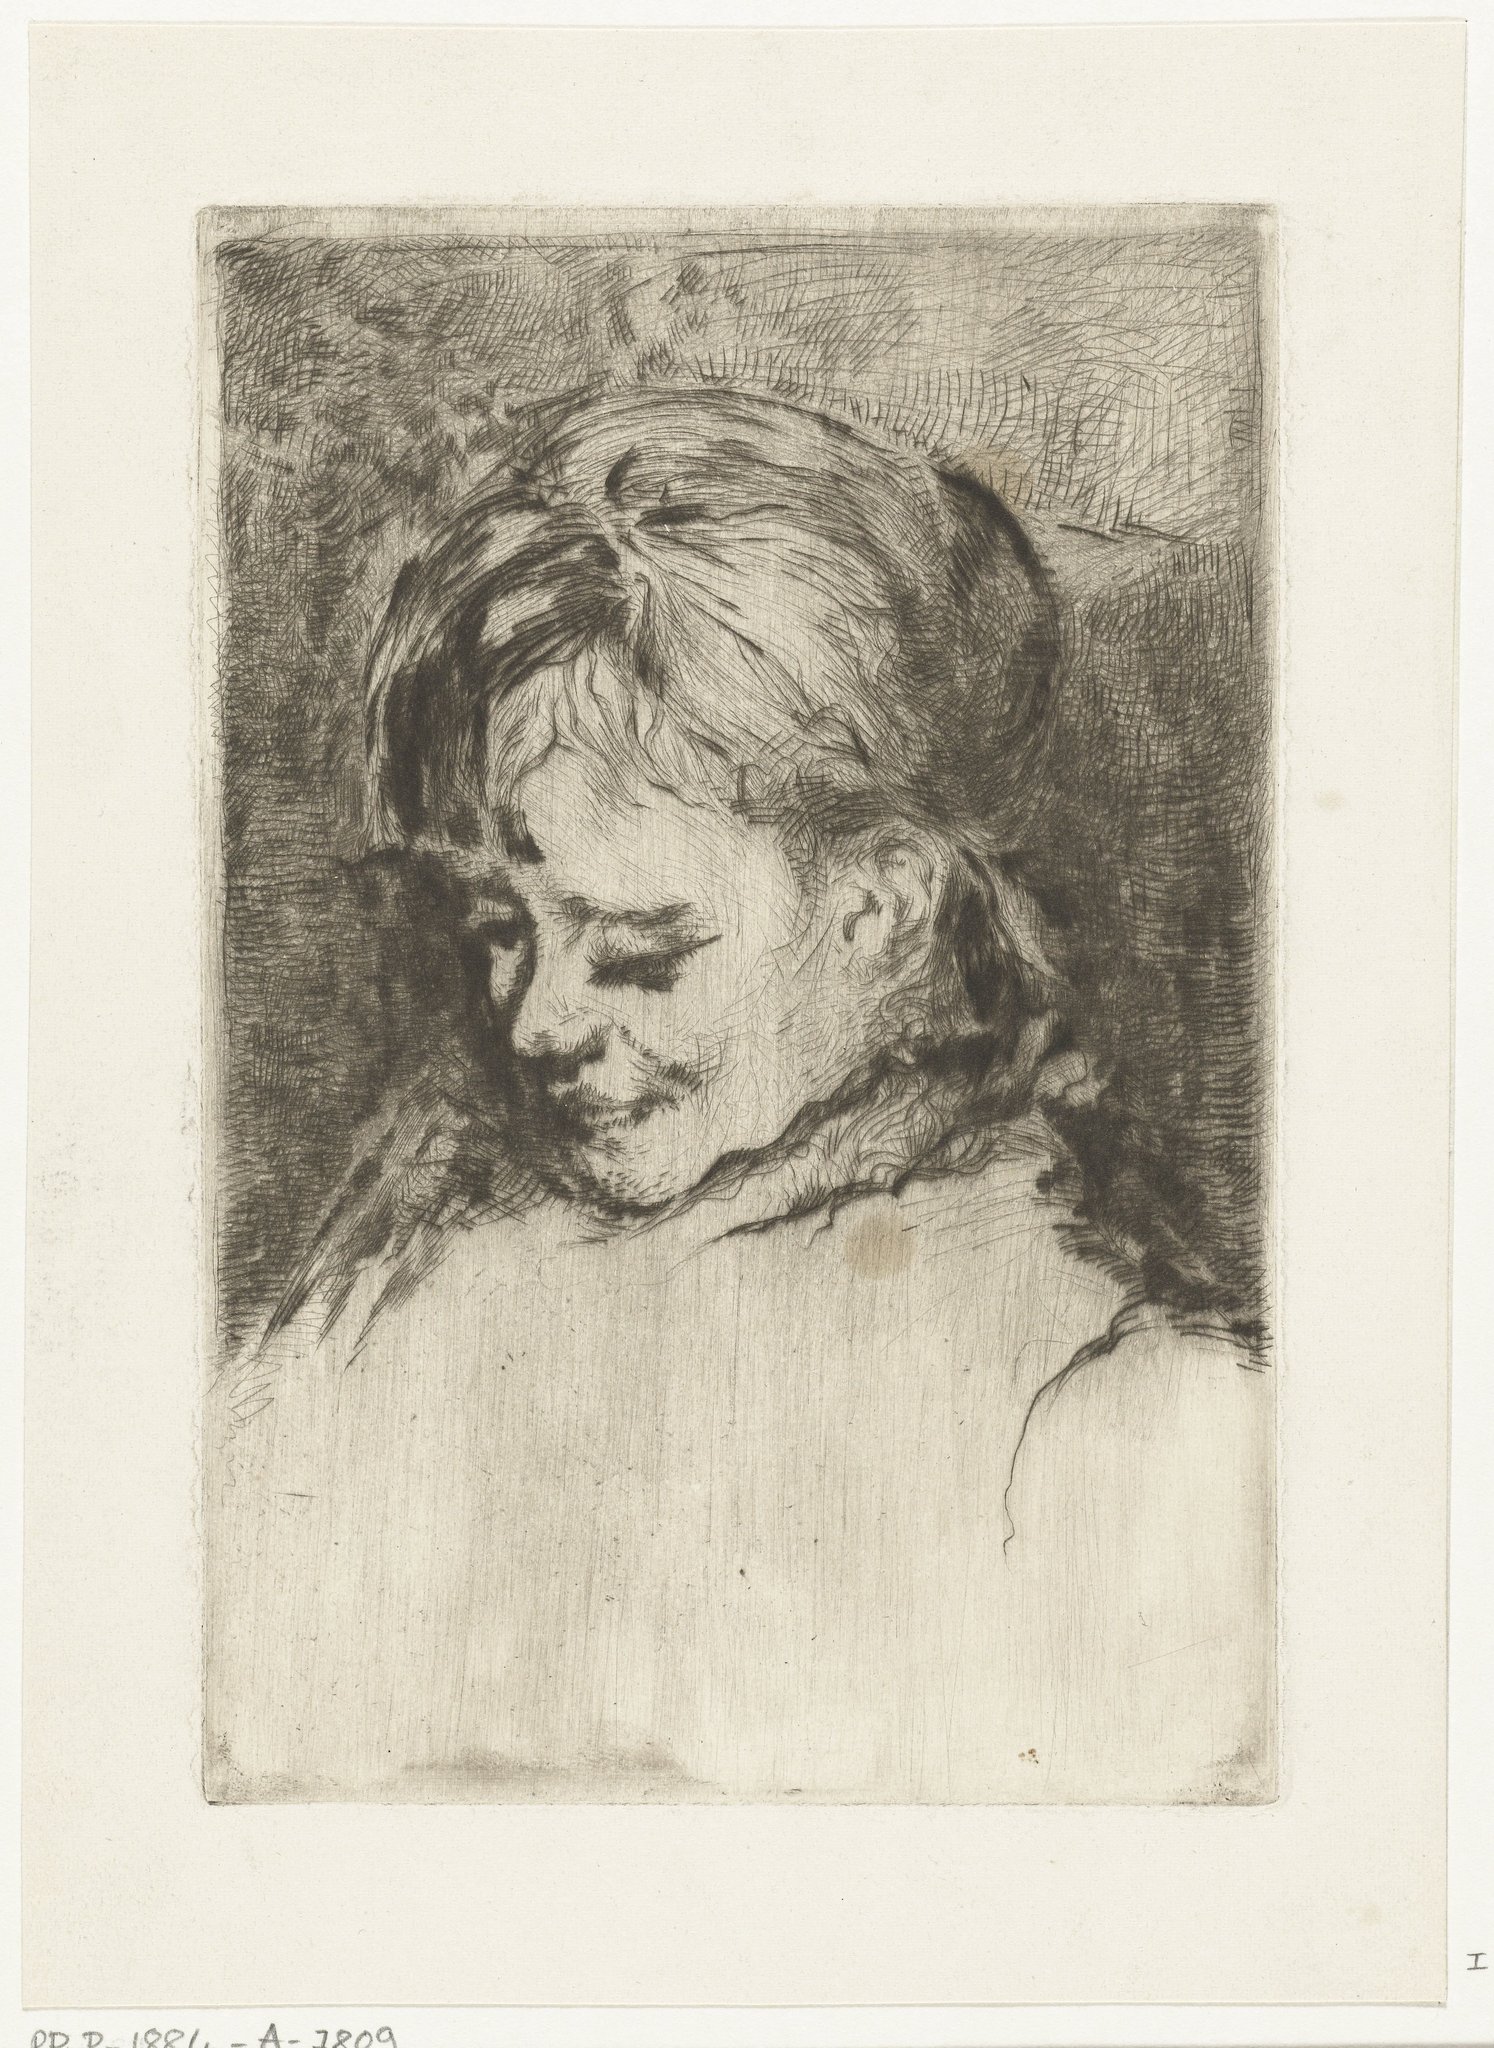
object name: print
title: Portret van een meisje, naar links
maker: gerard jan bos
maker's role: print maker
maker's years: 1860-1943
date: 1878-1884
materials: paper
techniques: drypoint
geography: antwerp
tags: female infant (+ three-quarter view)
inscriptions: collector's mark: Lugt 2228